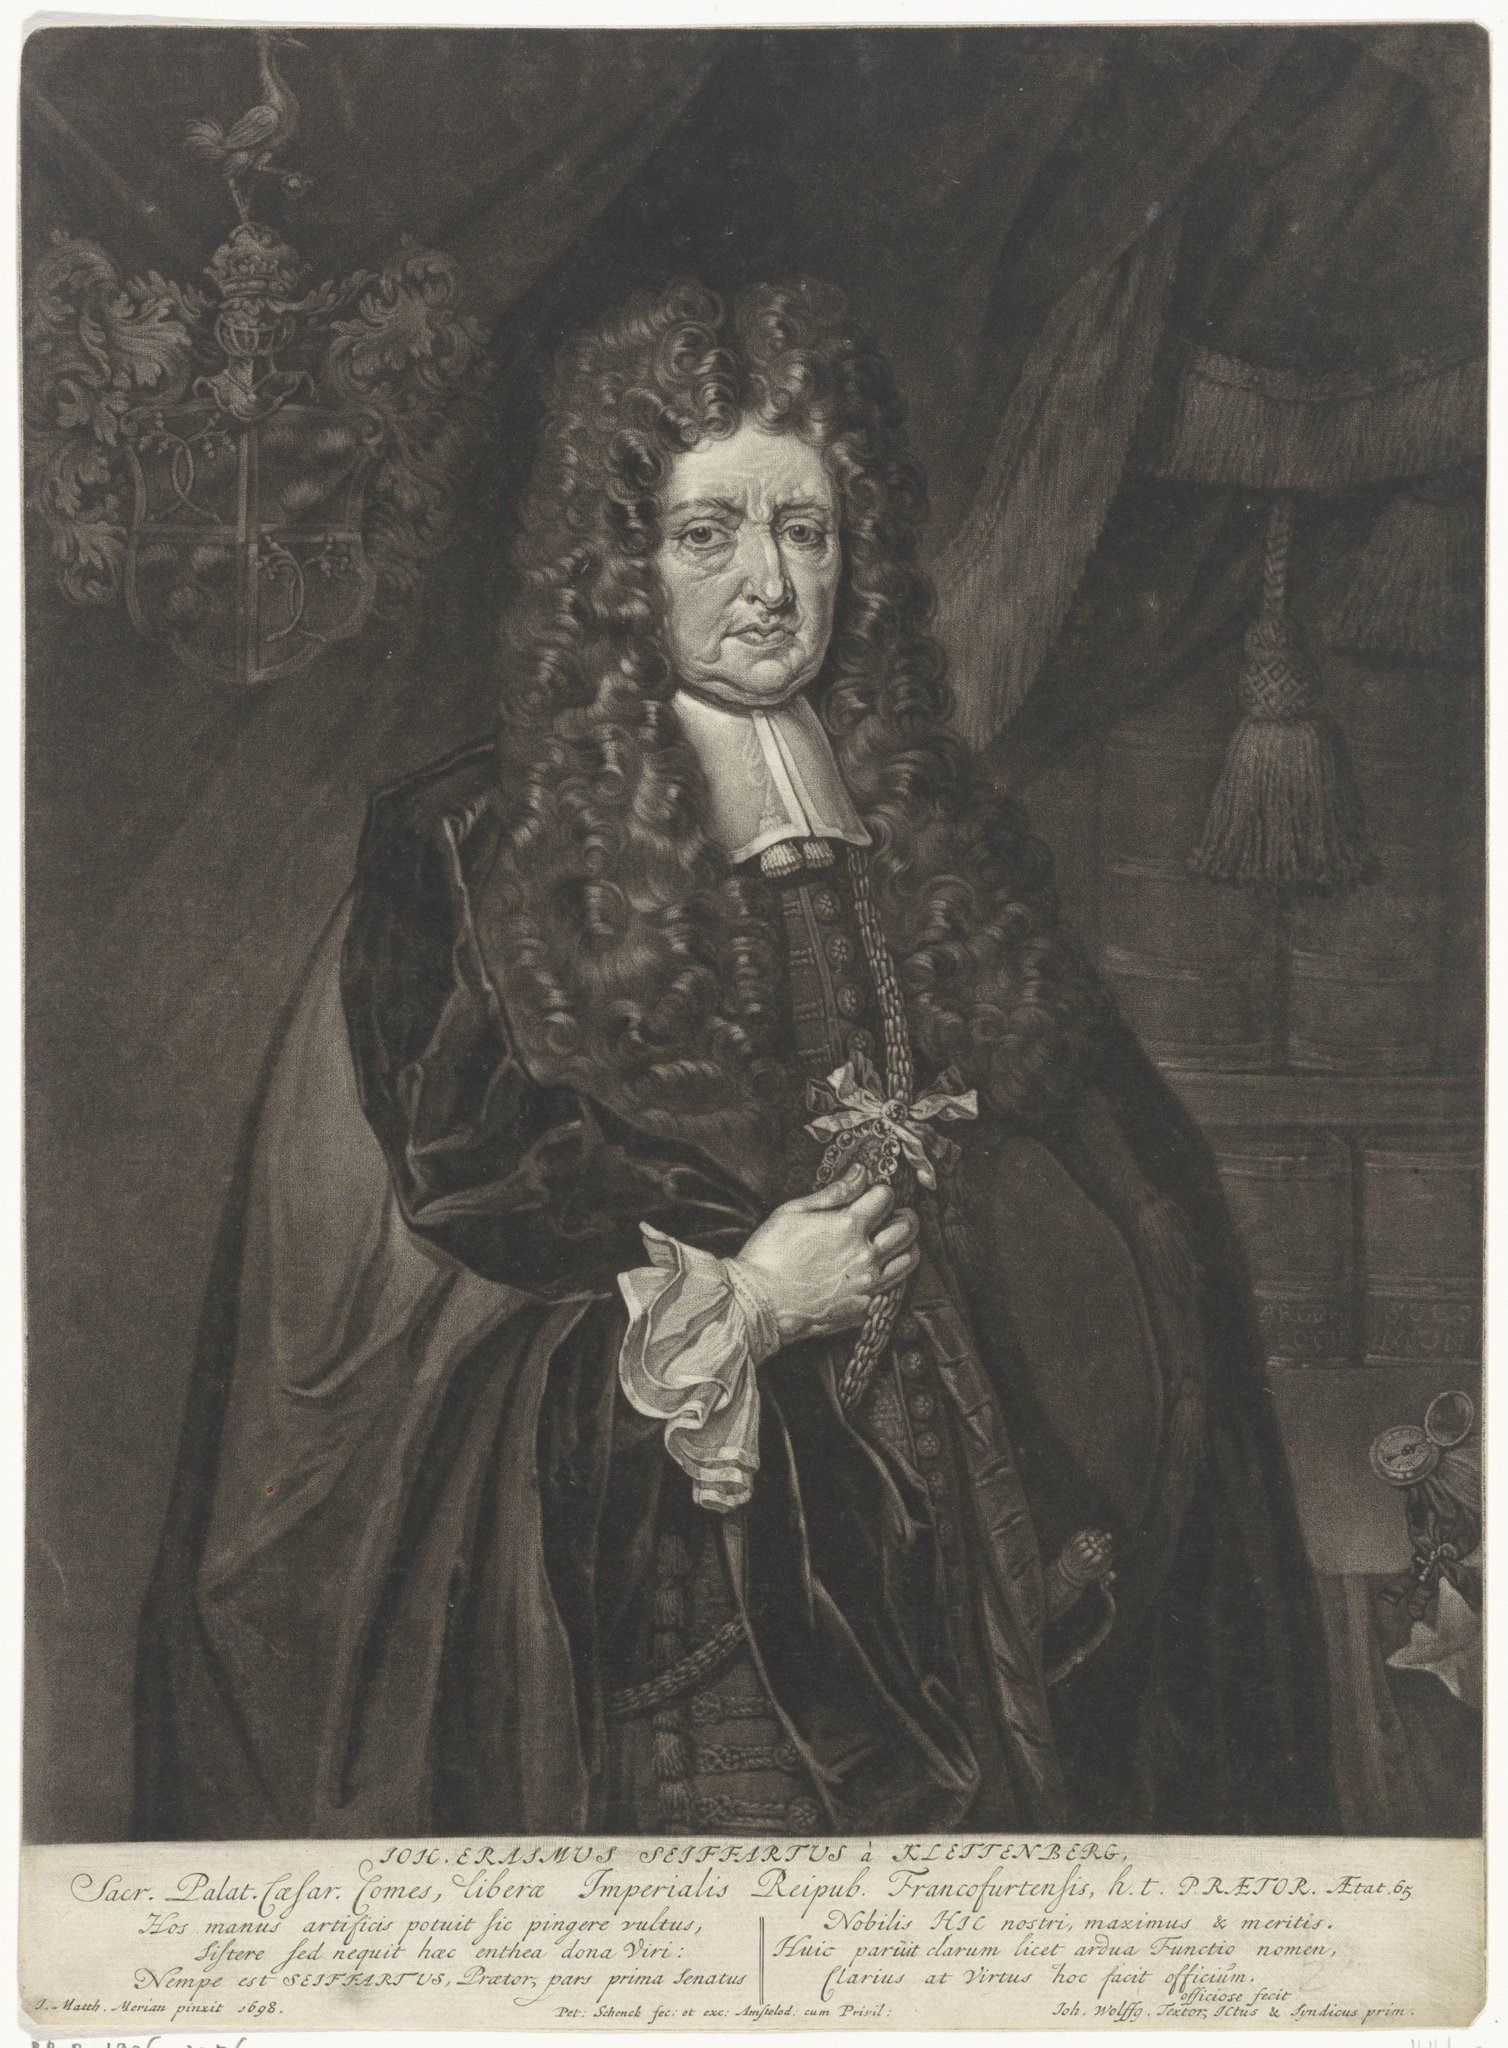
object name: print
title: Portret van Johann Erasmus Seiffert von Klettenberg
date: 1698-1713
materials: paper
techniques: engraving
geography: amsterdam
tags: johann erasmus seiffart von klettenberg, pendant, trinket, 'breloque', book, wig, watch, armorial bearing, heraldry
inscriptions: collector's mark: Lugt 2228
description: De Duitse jurist en schrijver Johann Erasmus Seiffert von Klettenberg, met in de hand een medaillon waarop het portret van een man. Achter hem een kast met boeken.